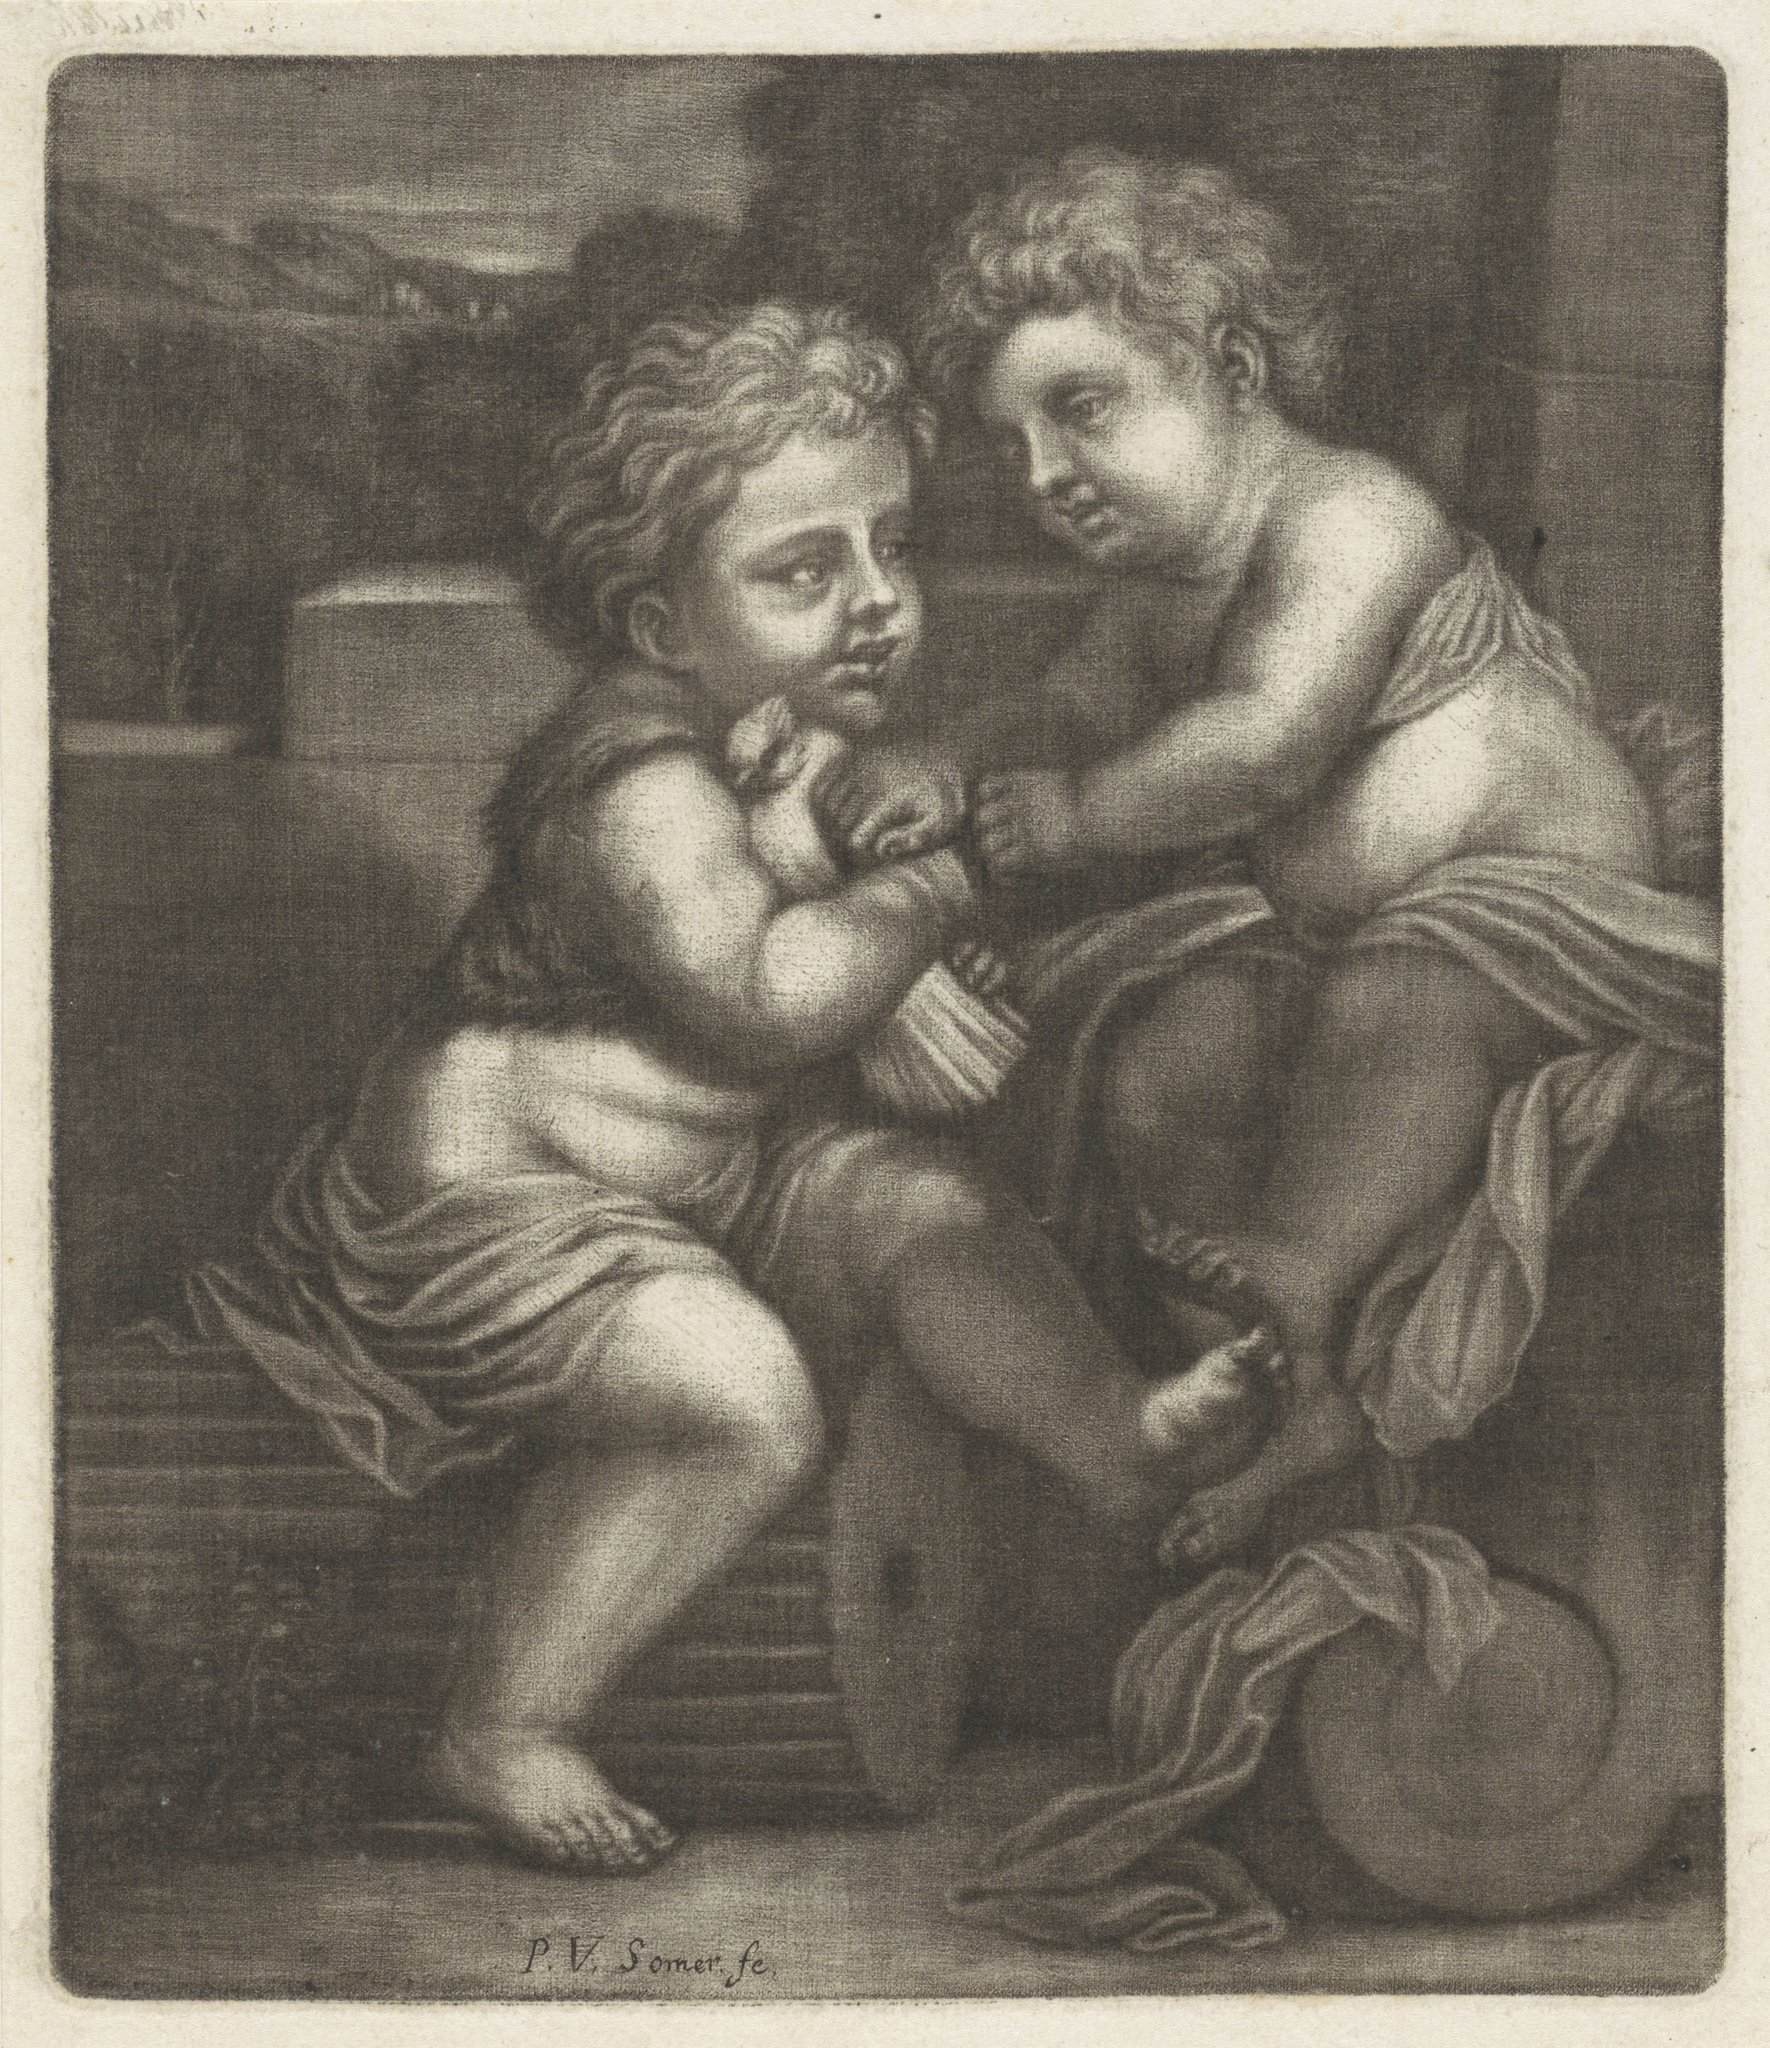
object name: print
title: Twee kinderen met een duif bij een ruïne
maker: paul van somer (ii)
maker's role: draughtsman, print maker, publisher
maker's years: 1639-1704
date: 1659-1694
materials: paper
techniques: mezzotint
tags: other birds: dove, landscape with ruins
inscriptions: collector's mark: Lugt 2228